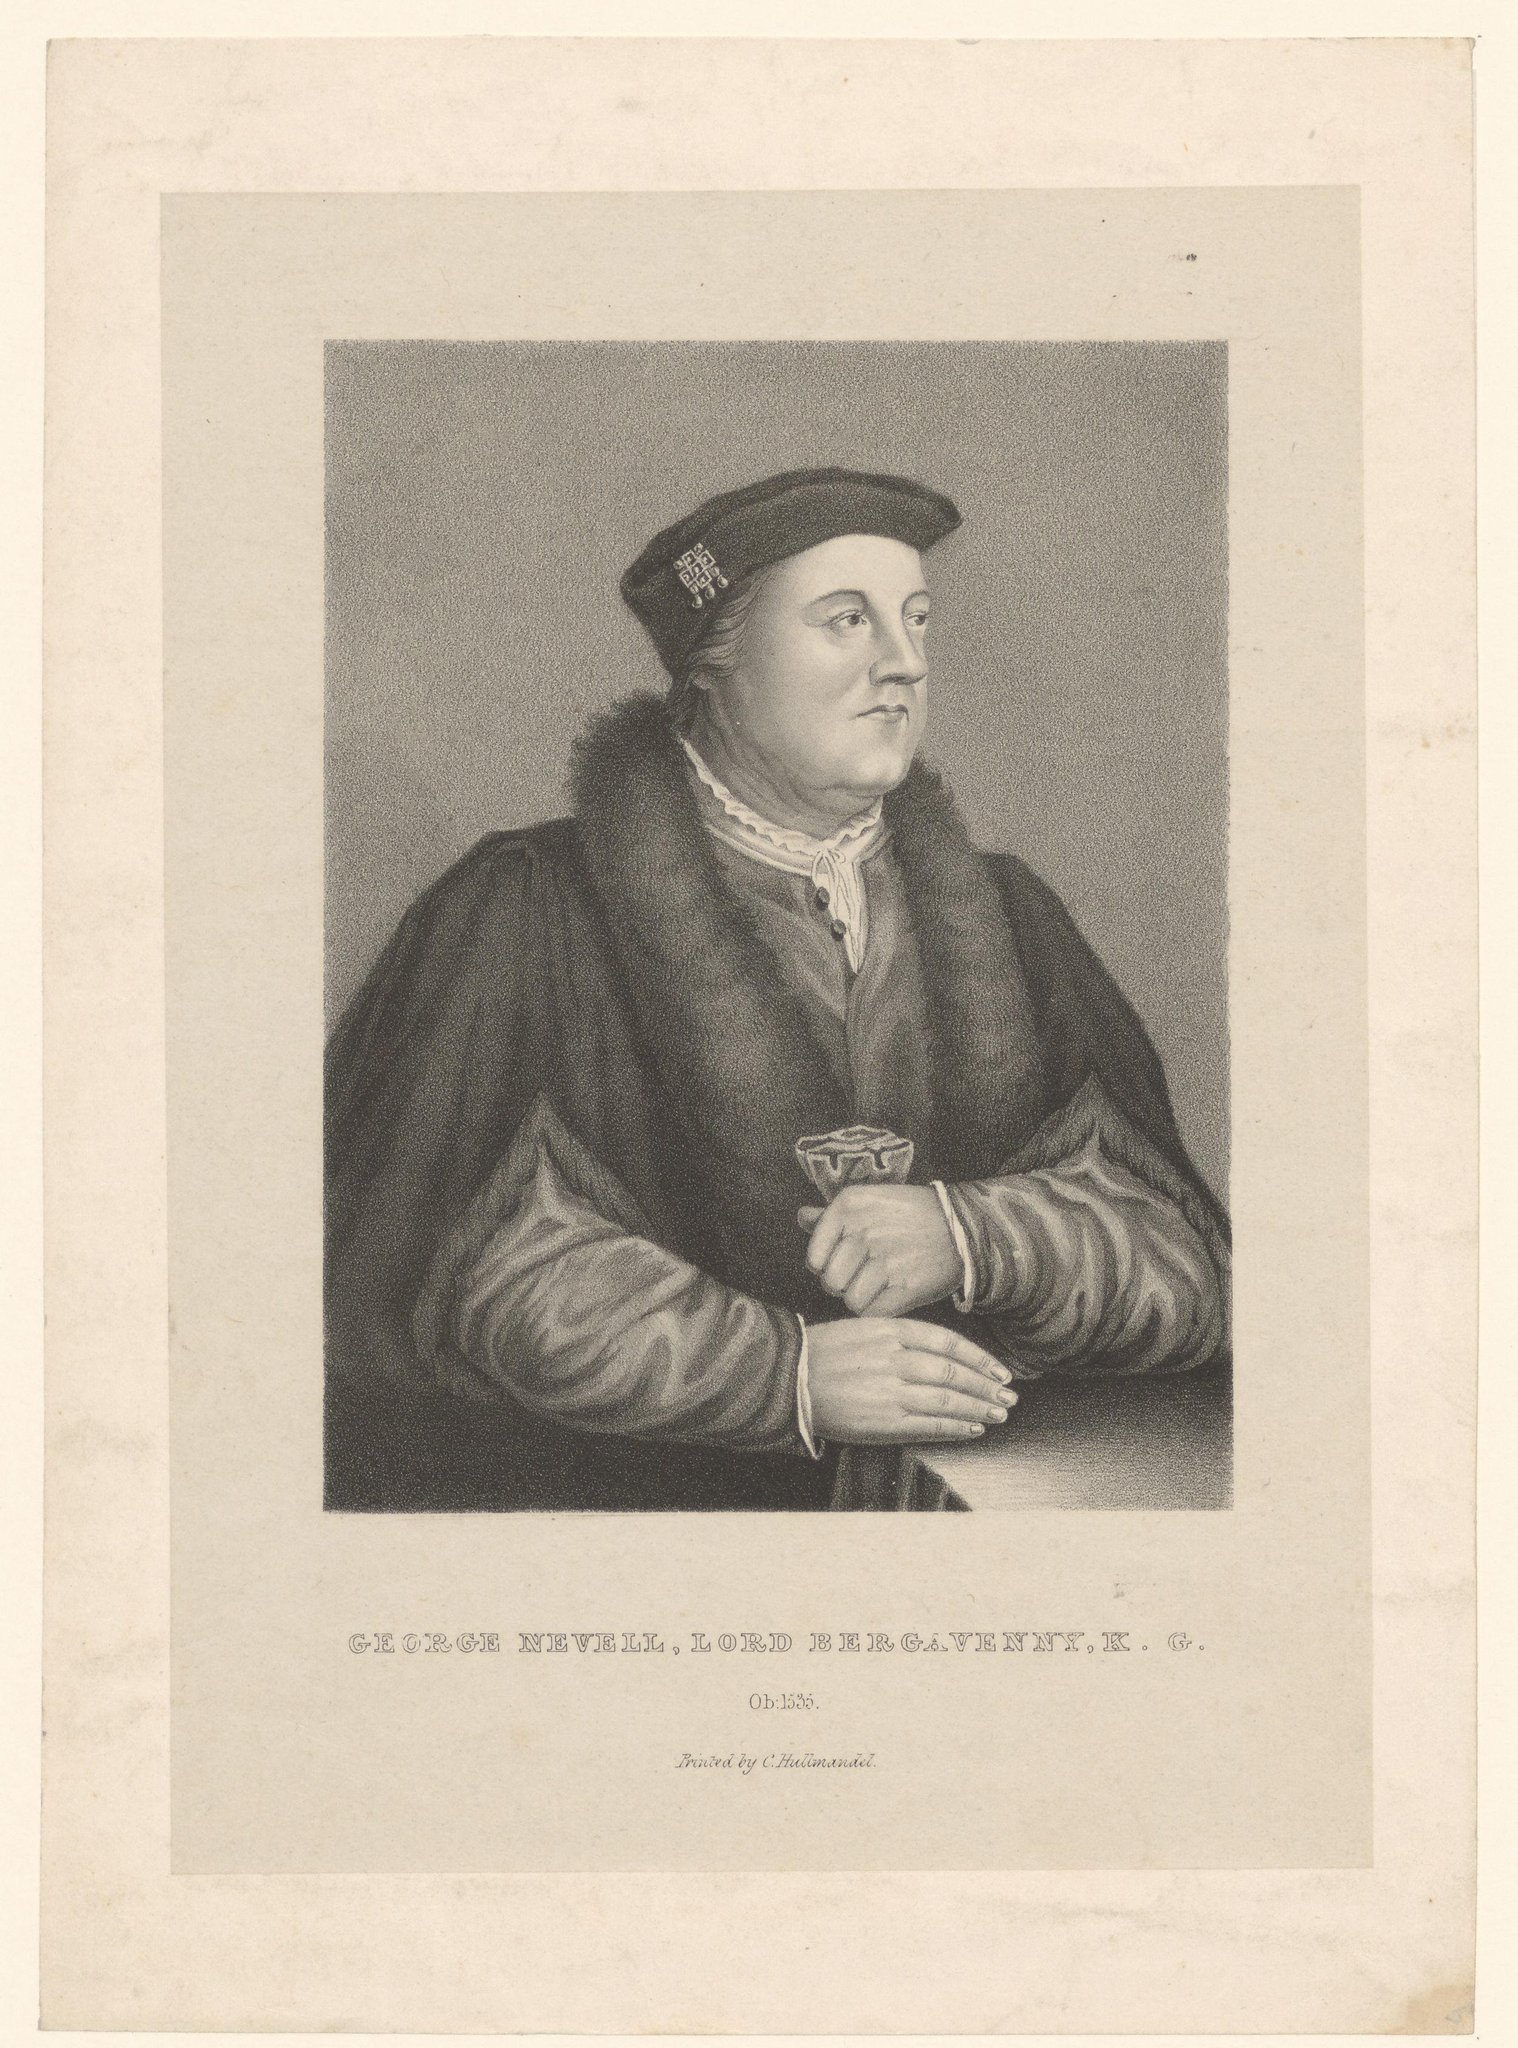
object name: print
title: George Nevell, lord Bergavenny, K.G.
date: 1799-1850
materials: paper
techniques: lithograph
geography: london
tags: head-gear, adult man, historical persons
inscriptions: collector's mark: Lugt 2228